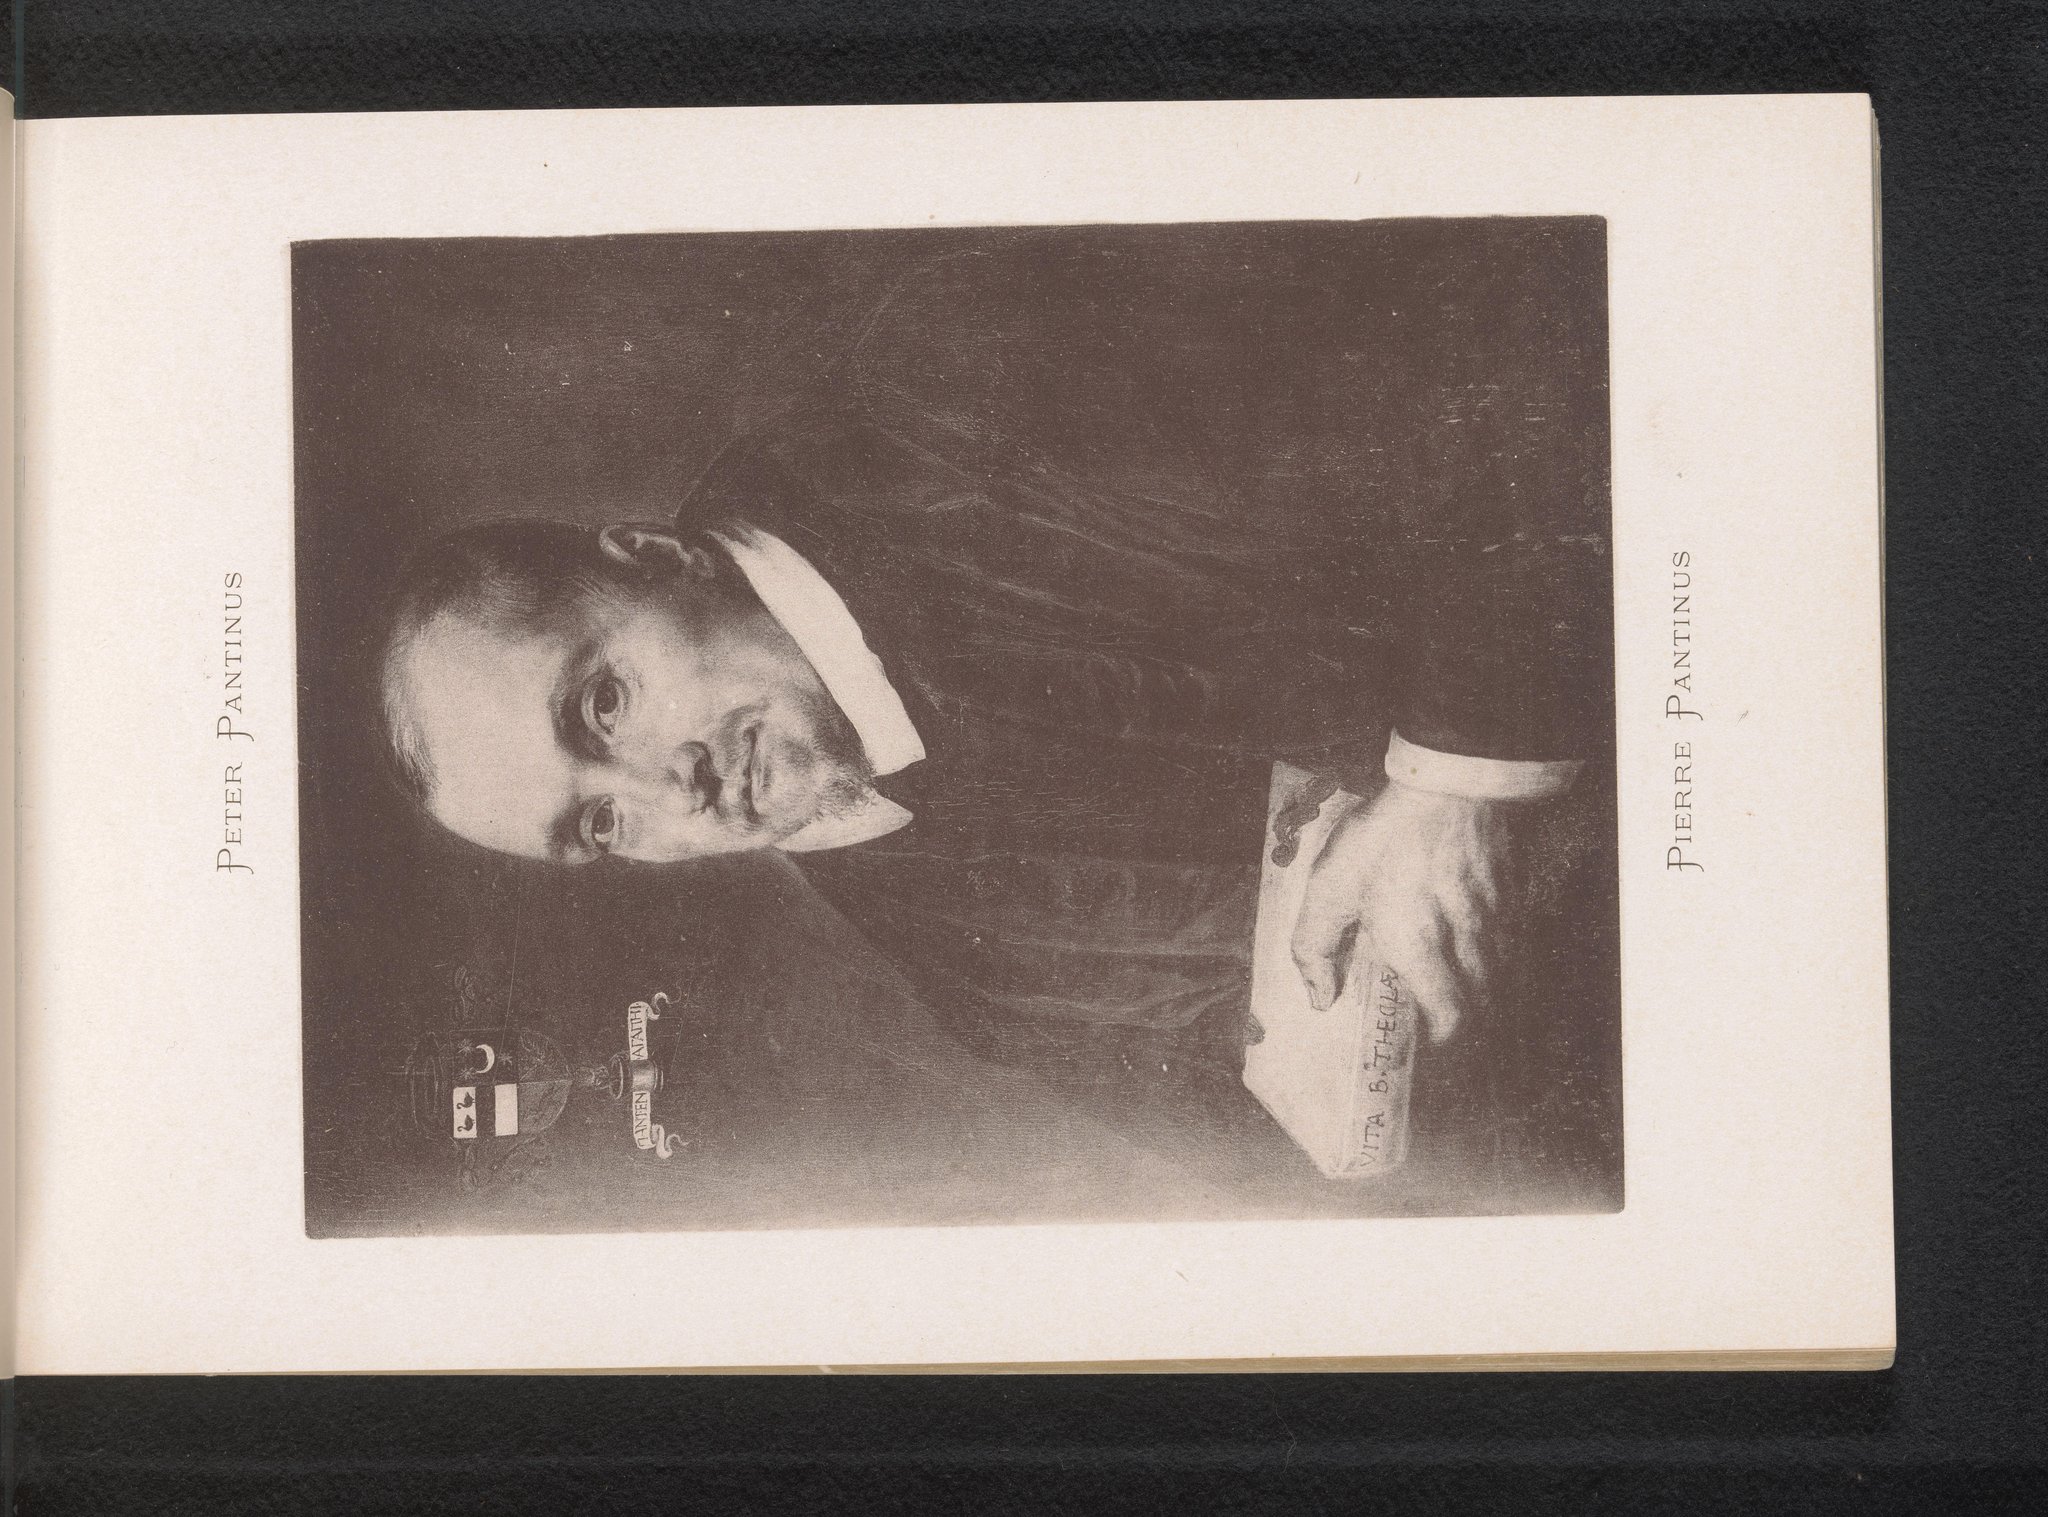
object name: reproduction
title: Peter Pantinus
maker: Anonymous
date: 1892-1897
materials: paper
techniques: photograph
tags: adult man